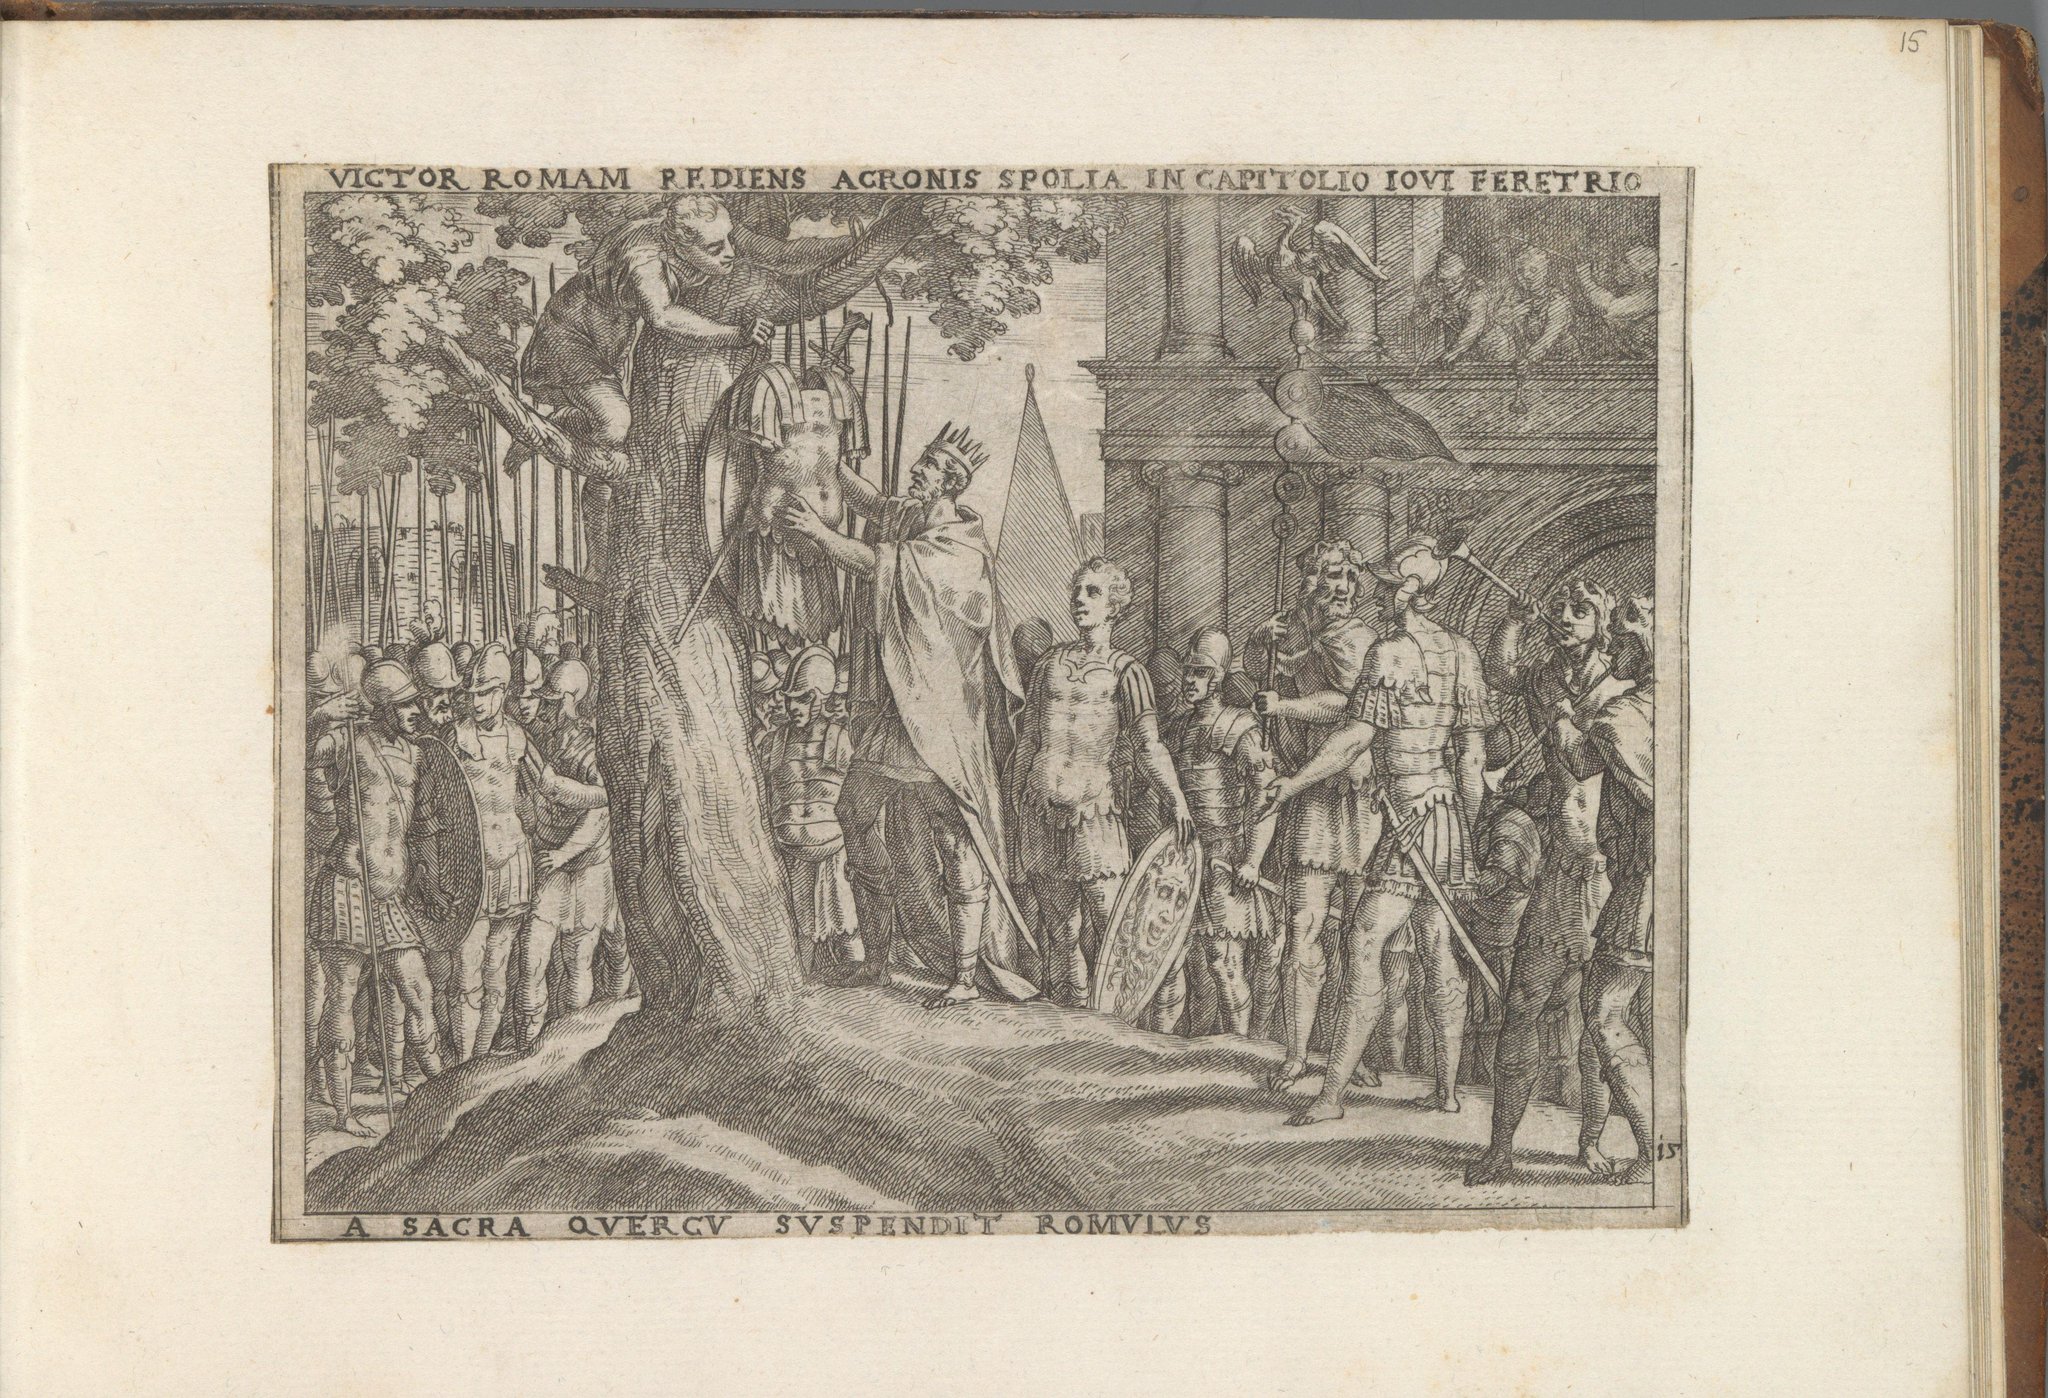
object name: album leaf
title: Leven van Romulus en Remus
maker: giovanni battista fontana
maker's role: draughtsman, painter, print maker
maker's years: 1524-1587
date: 1572-1573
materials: paper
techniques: etching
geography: italy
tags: (story of) romulus and remus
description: Romulus hangt het harnas van Acron in een boom op het Capitool te Rome. Soldaten kijken toe. De prent maakt deel uit van een album.